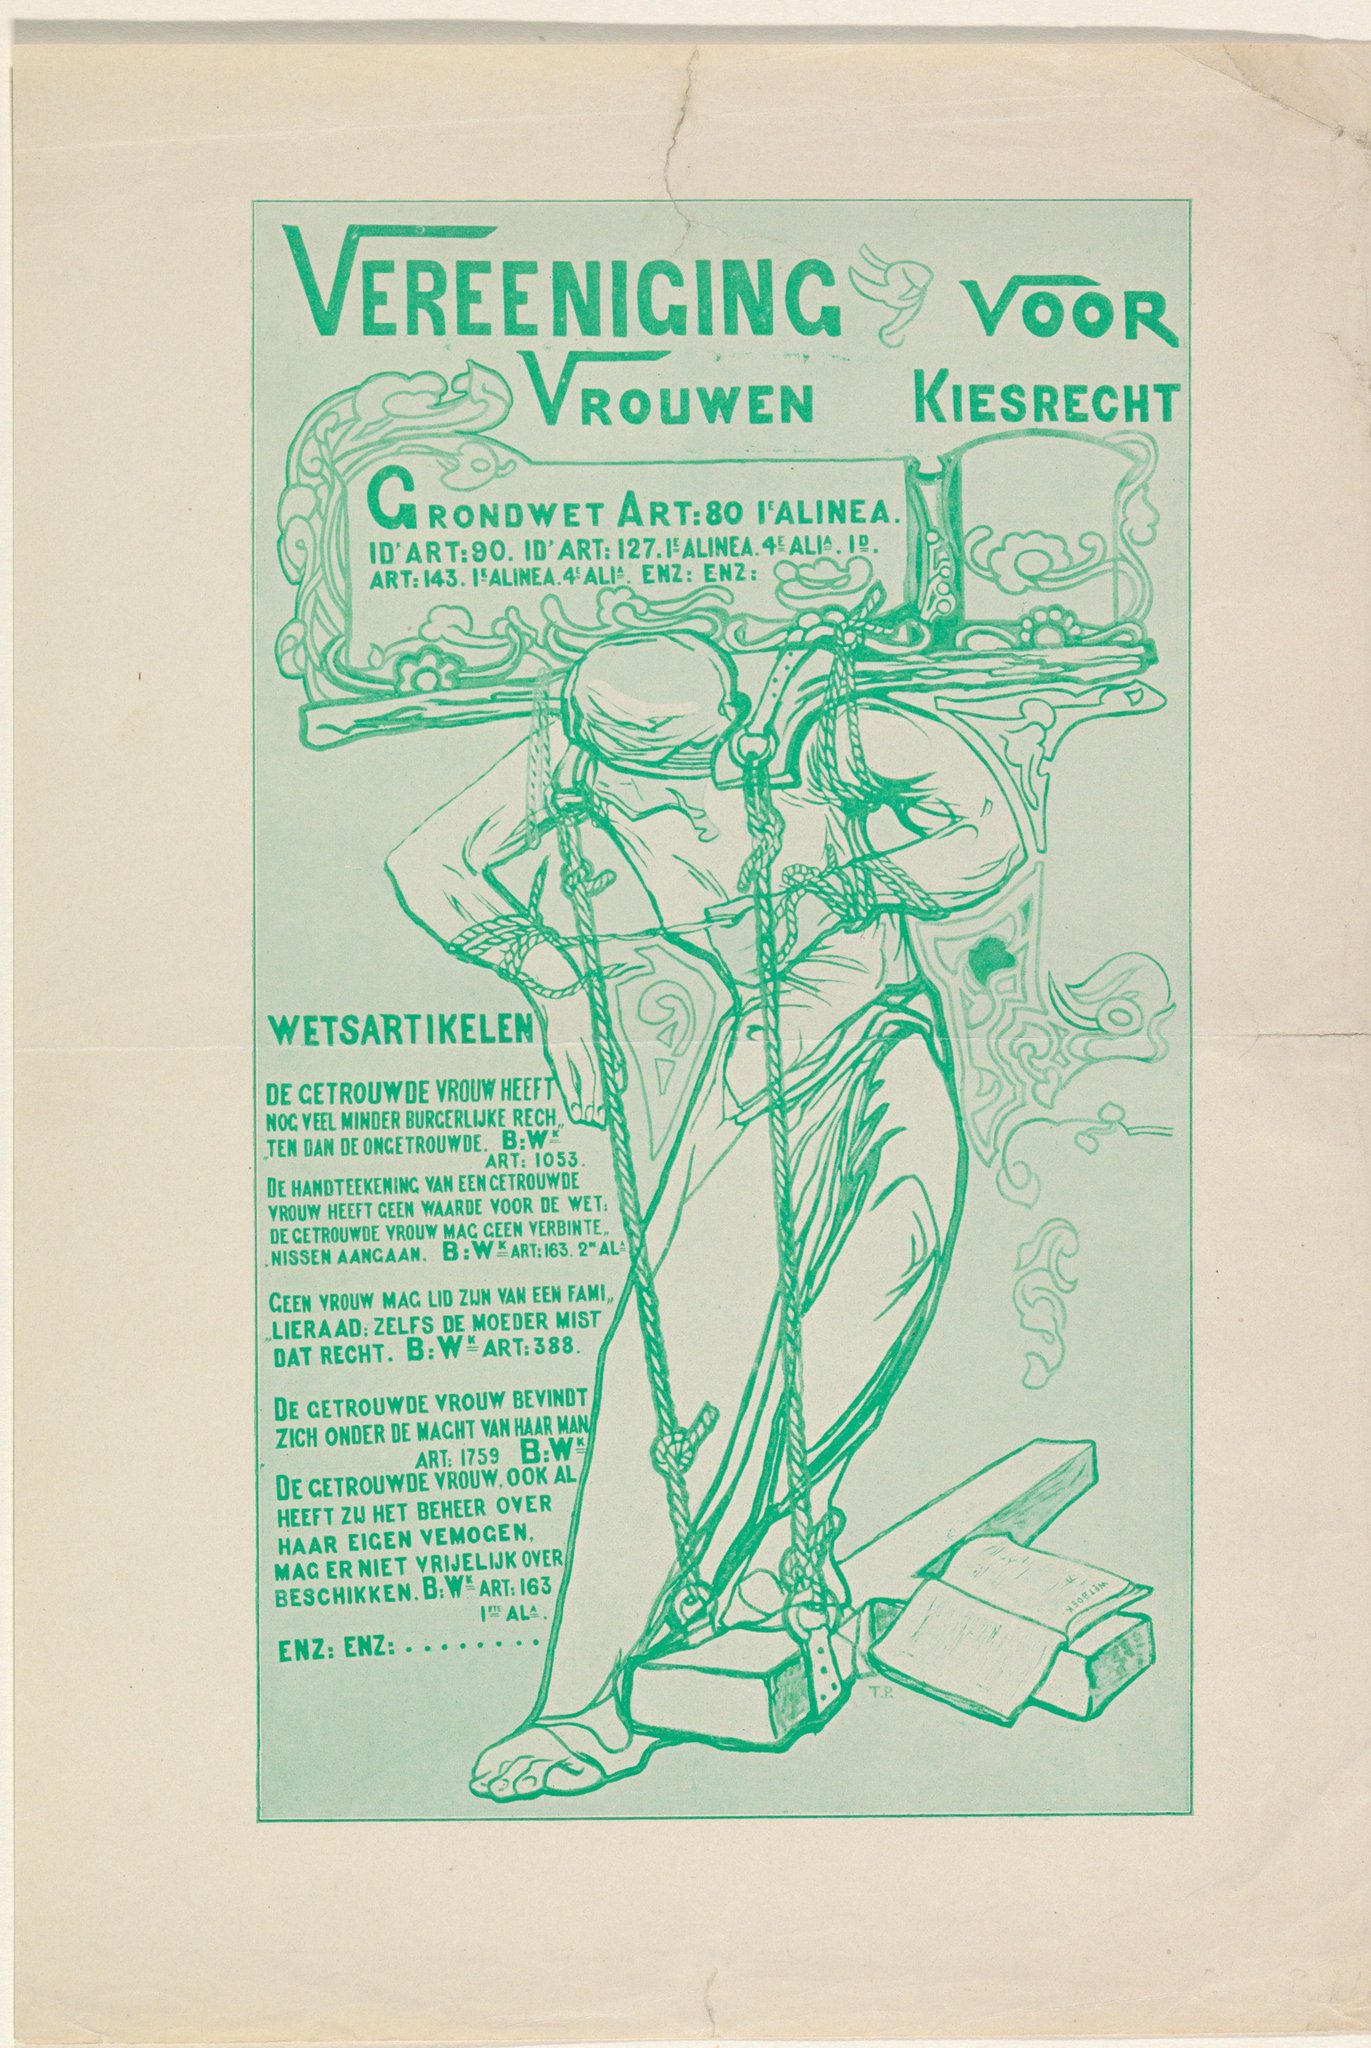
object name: print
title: Pamflet van de Vereeniging voor Vrouwenkiesrecht, ca. 1916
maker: Anonymous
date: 1914-1918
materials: paper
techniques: printed materials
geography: netherlands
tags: vereeniging voor vrouwenkiesrecht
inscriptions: collector's mark: Lugt Lugt 2228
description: Pamflet of affiche van de Vereeniging voor Vrouwenkiesrecht, ca. 1916. Een vrouw ontdoet zich van het juk en de touwen die haar binden. Links worden verschillende discriminerende wetsartikelen geciteerd.